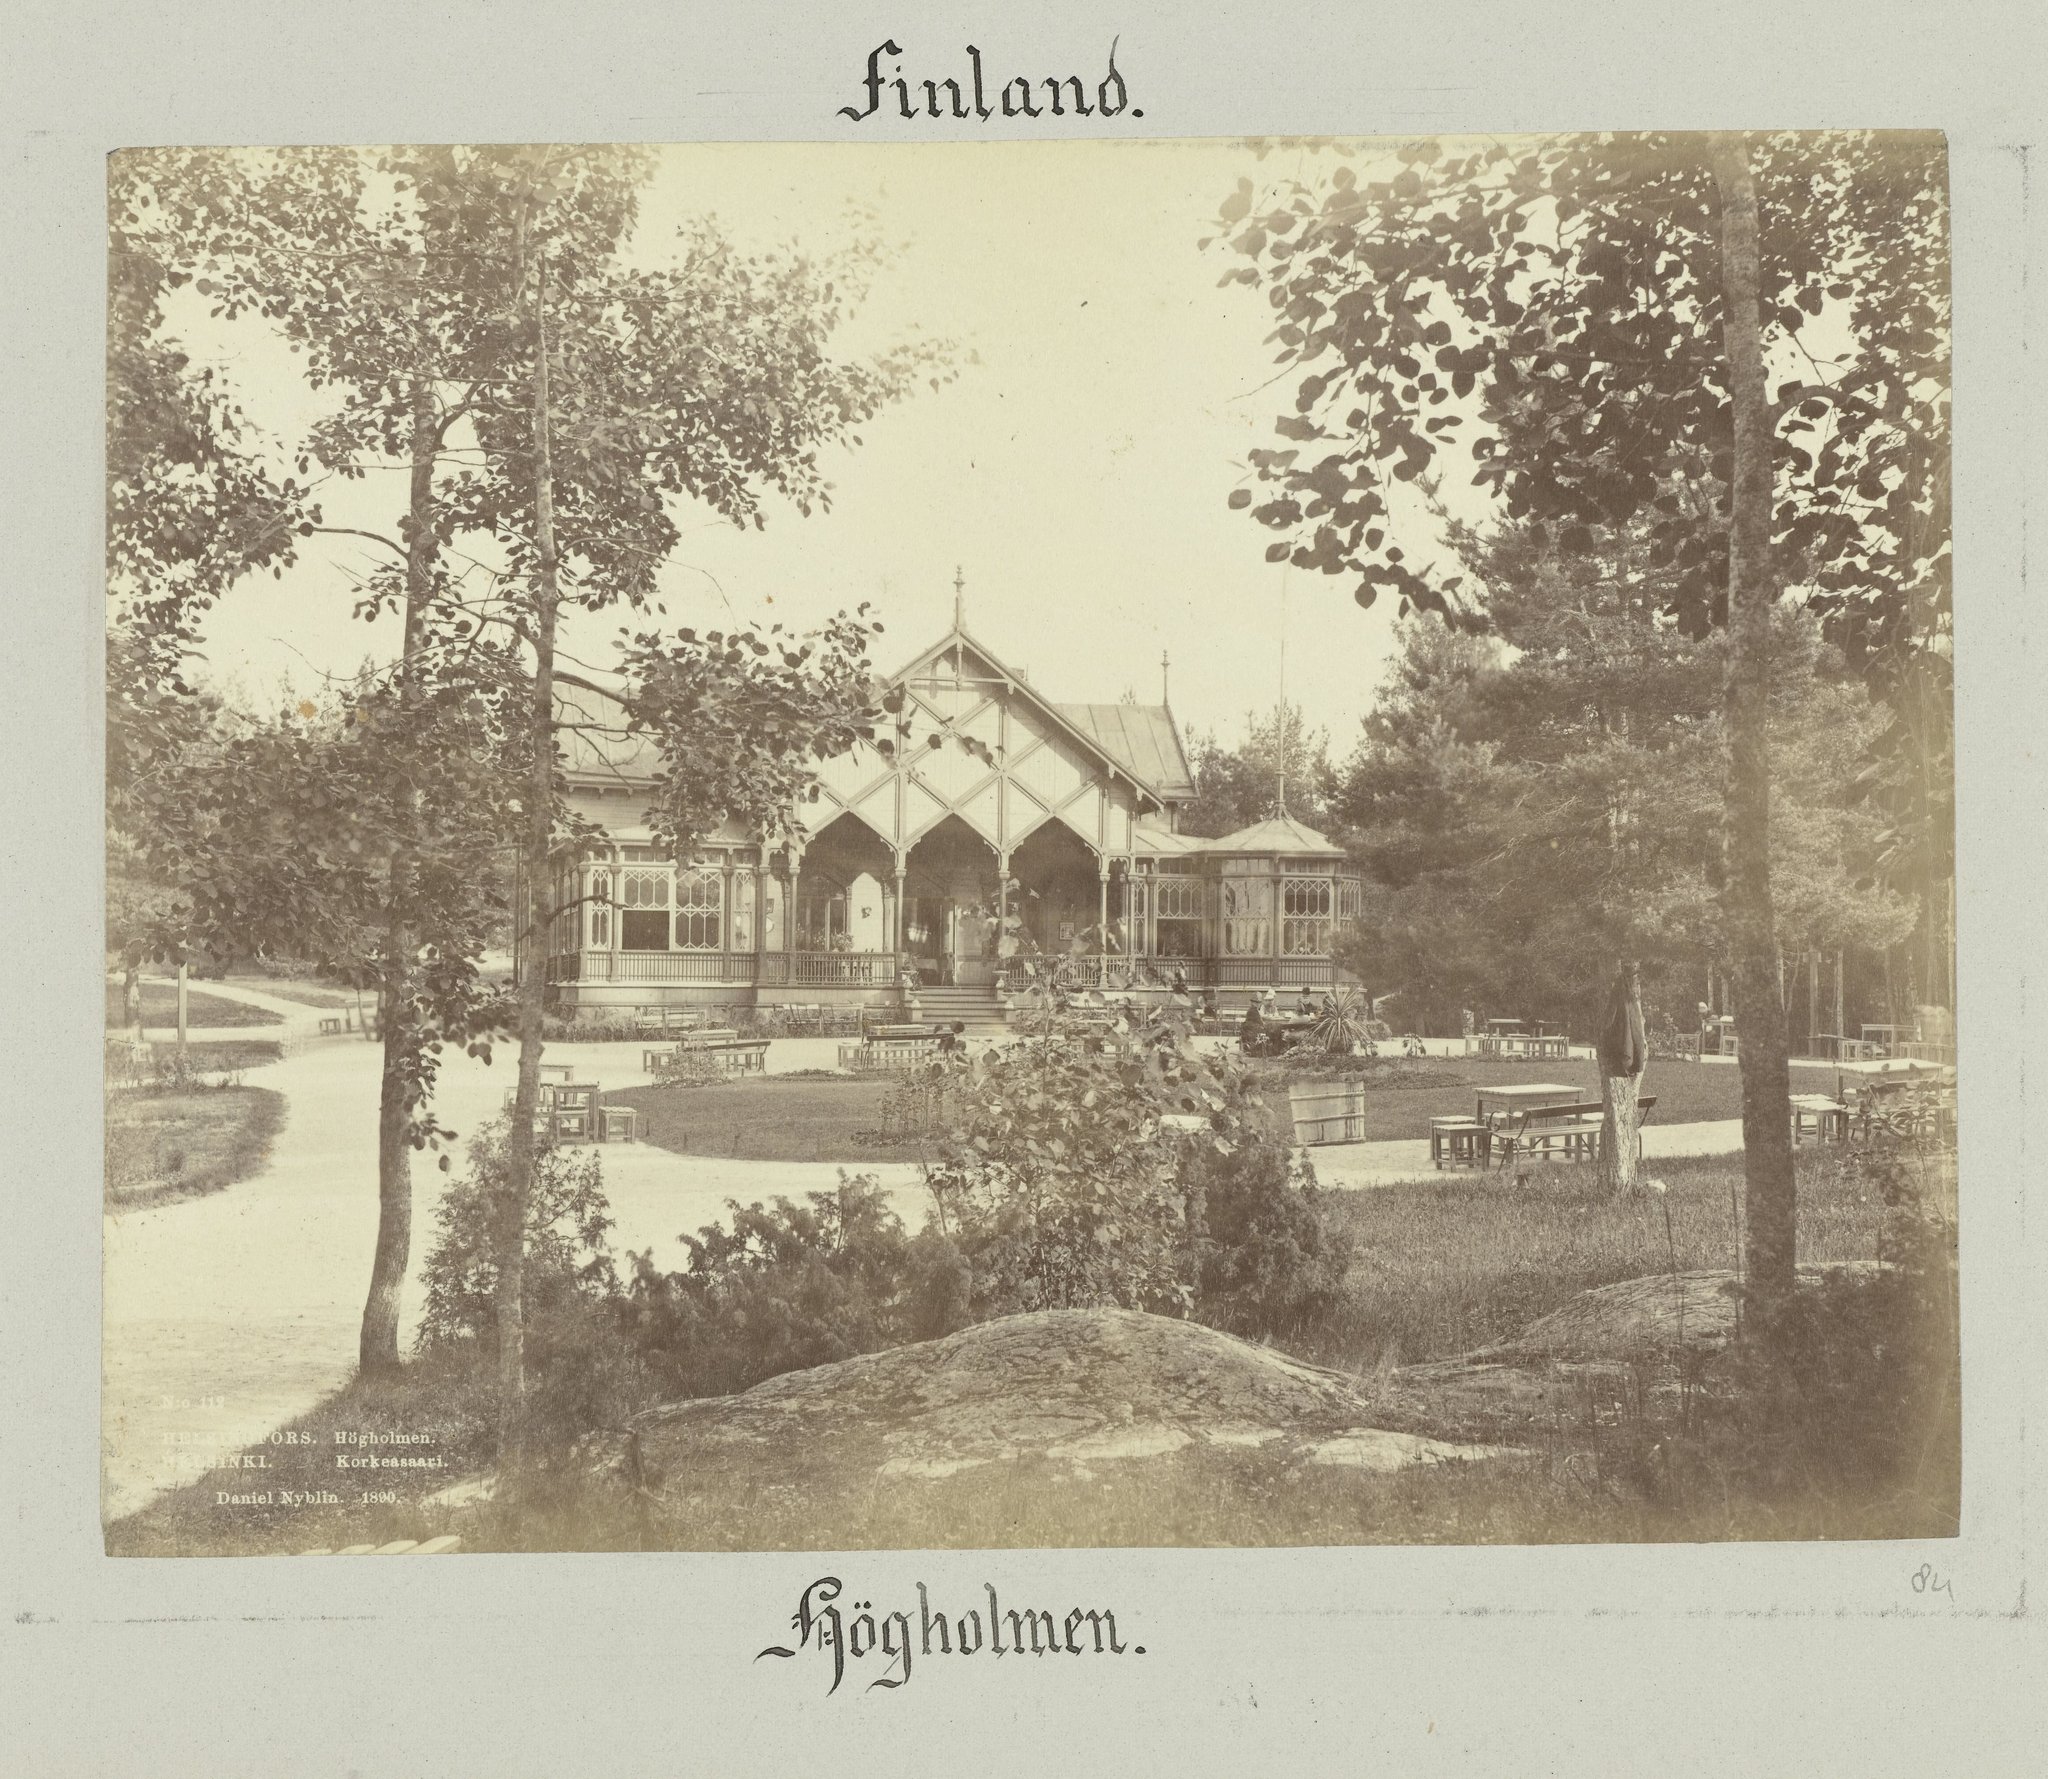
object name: photograph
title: Helsinki Korkeasaari, Daniel Nyblin 1890.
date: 1898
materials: paper, photographic support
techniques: albumen print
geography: netherlands